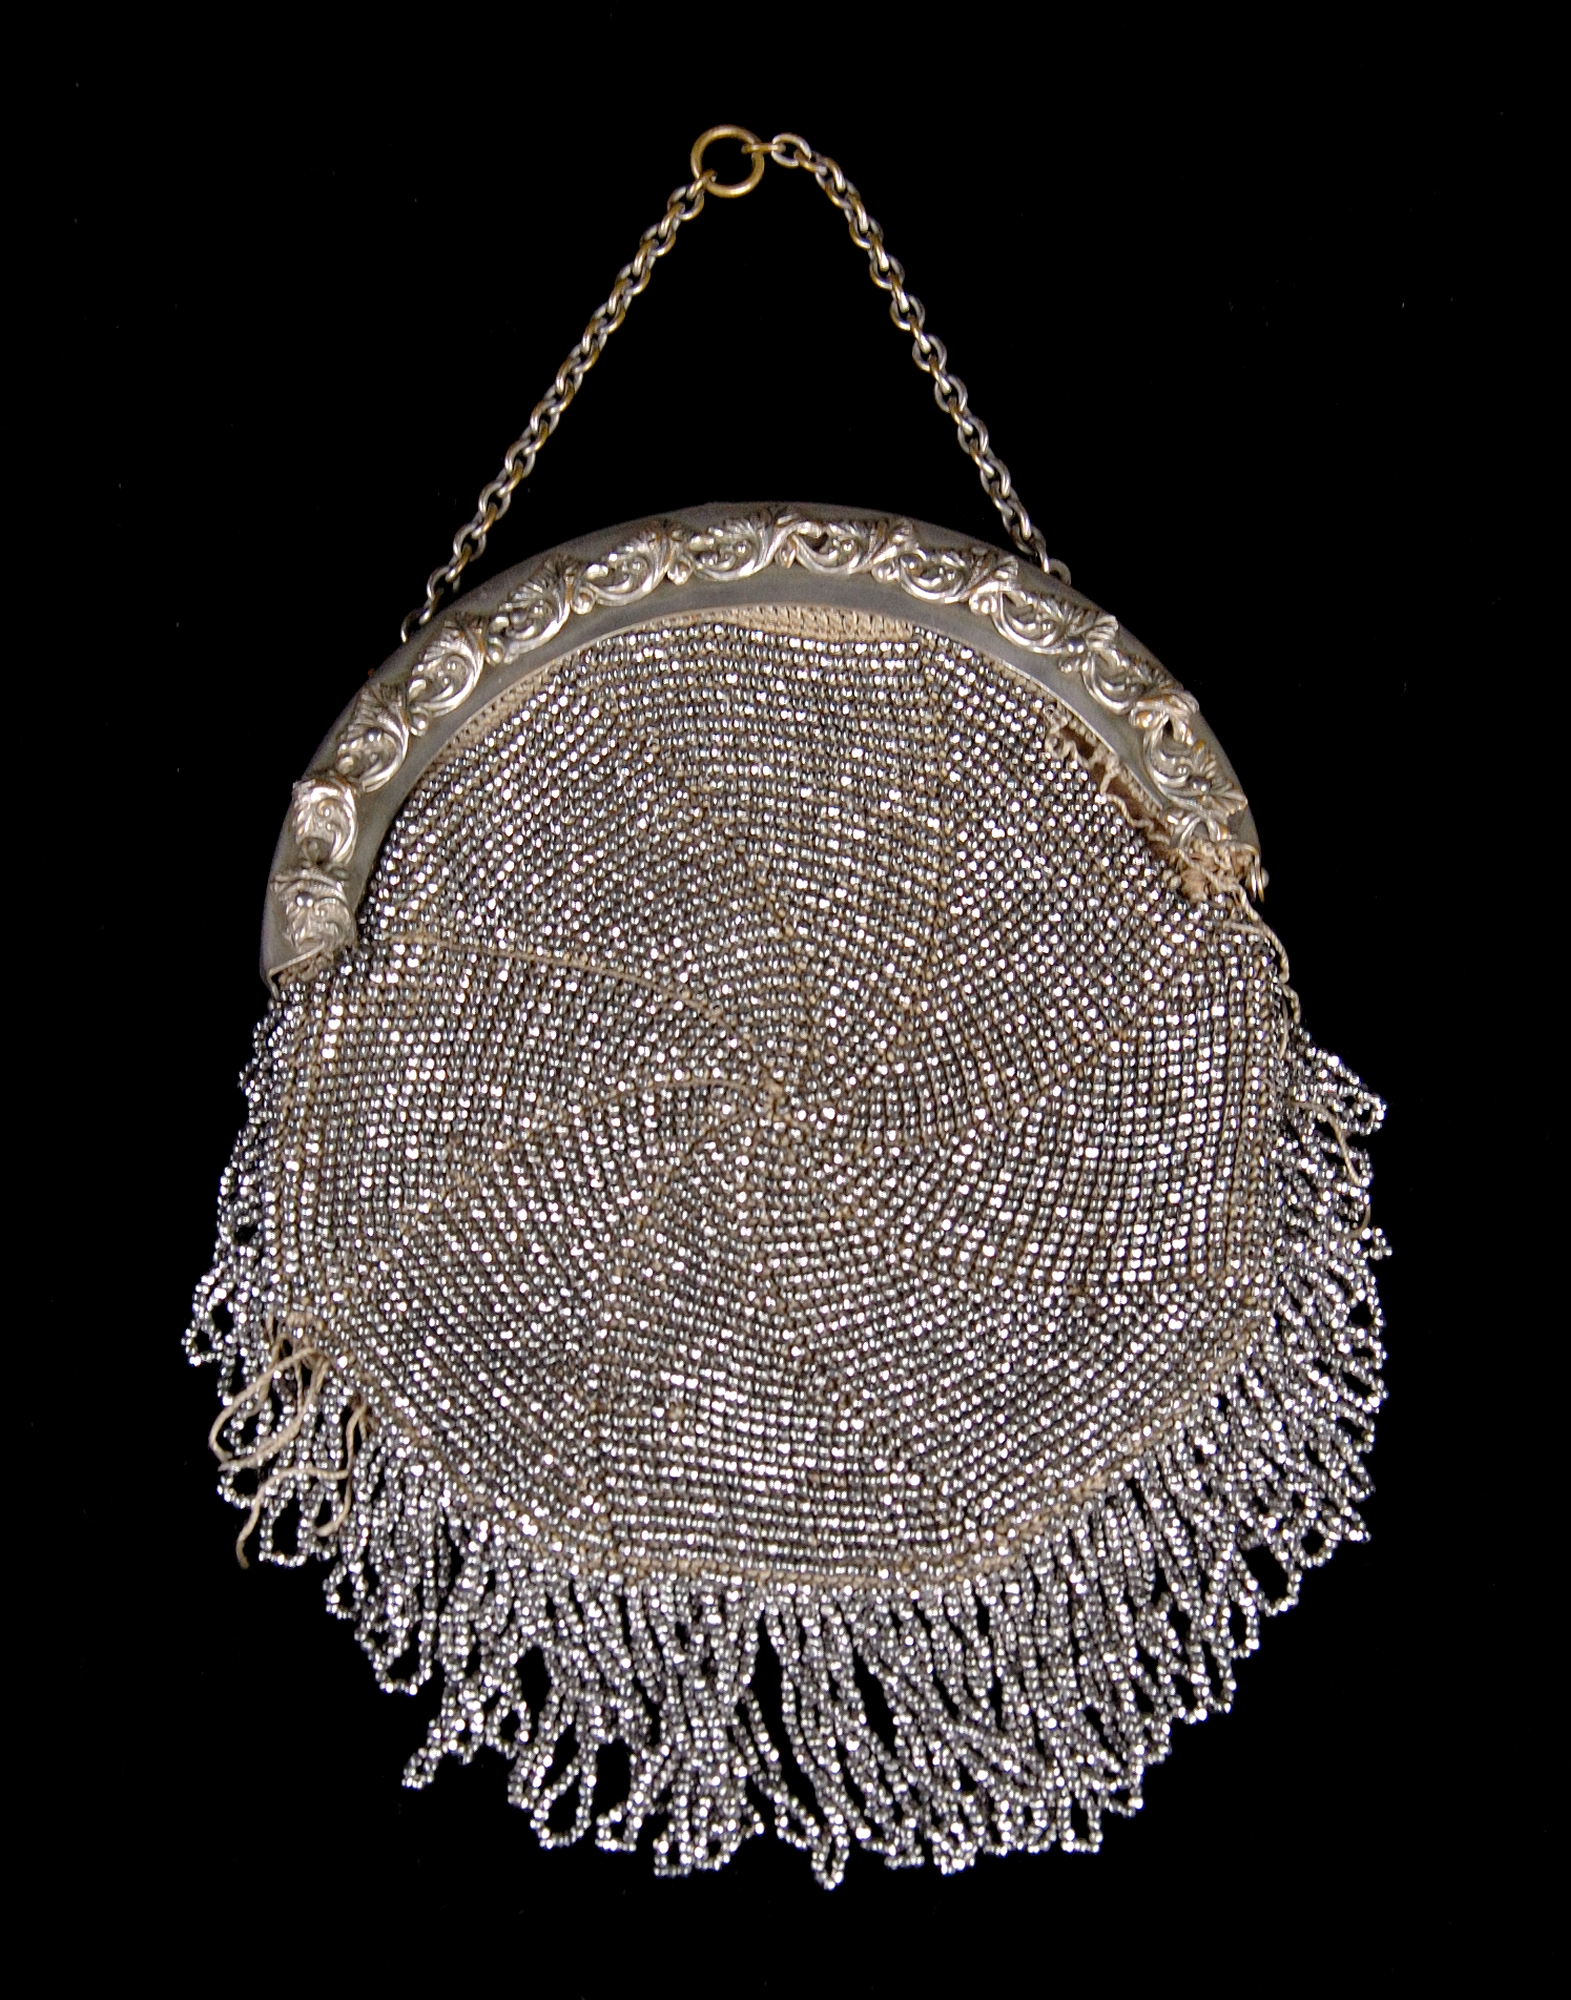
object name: evening bag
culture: european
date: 1850-1859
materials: cotton, metal